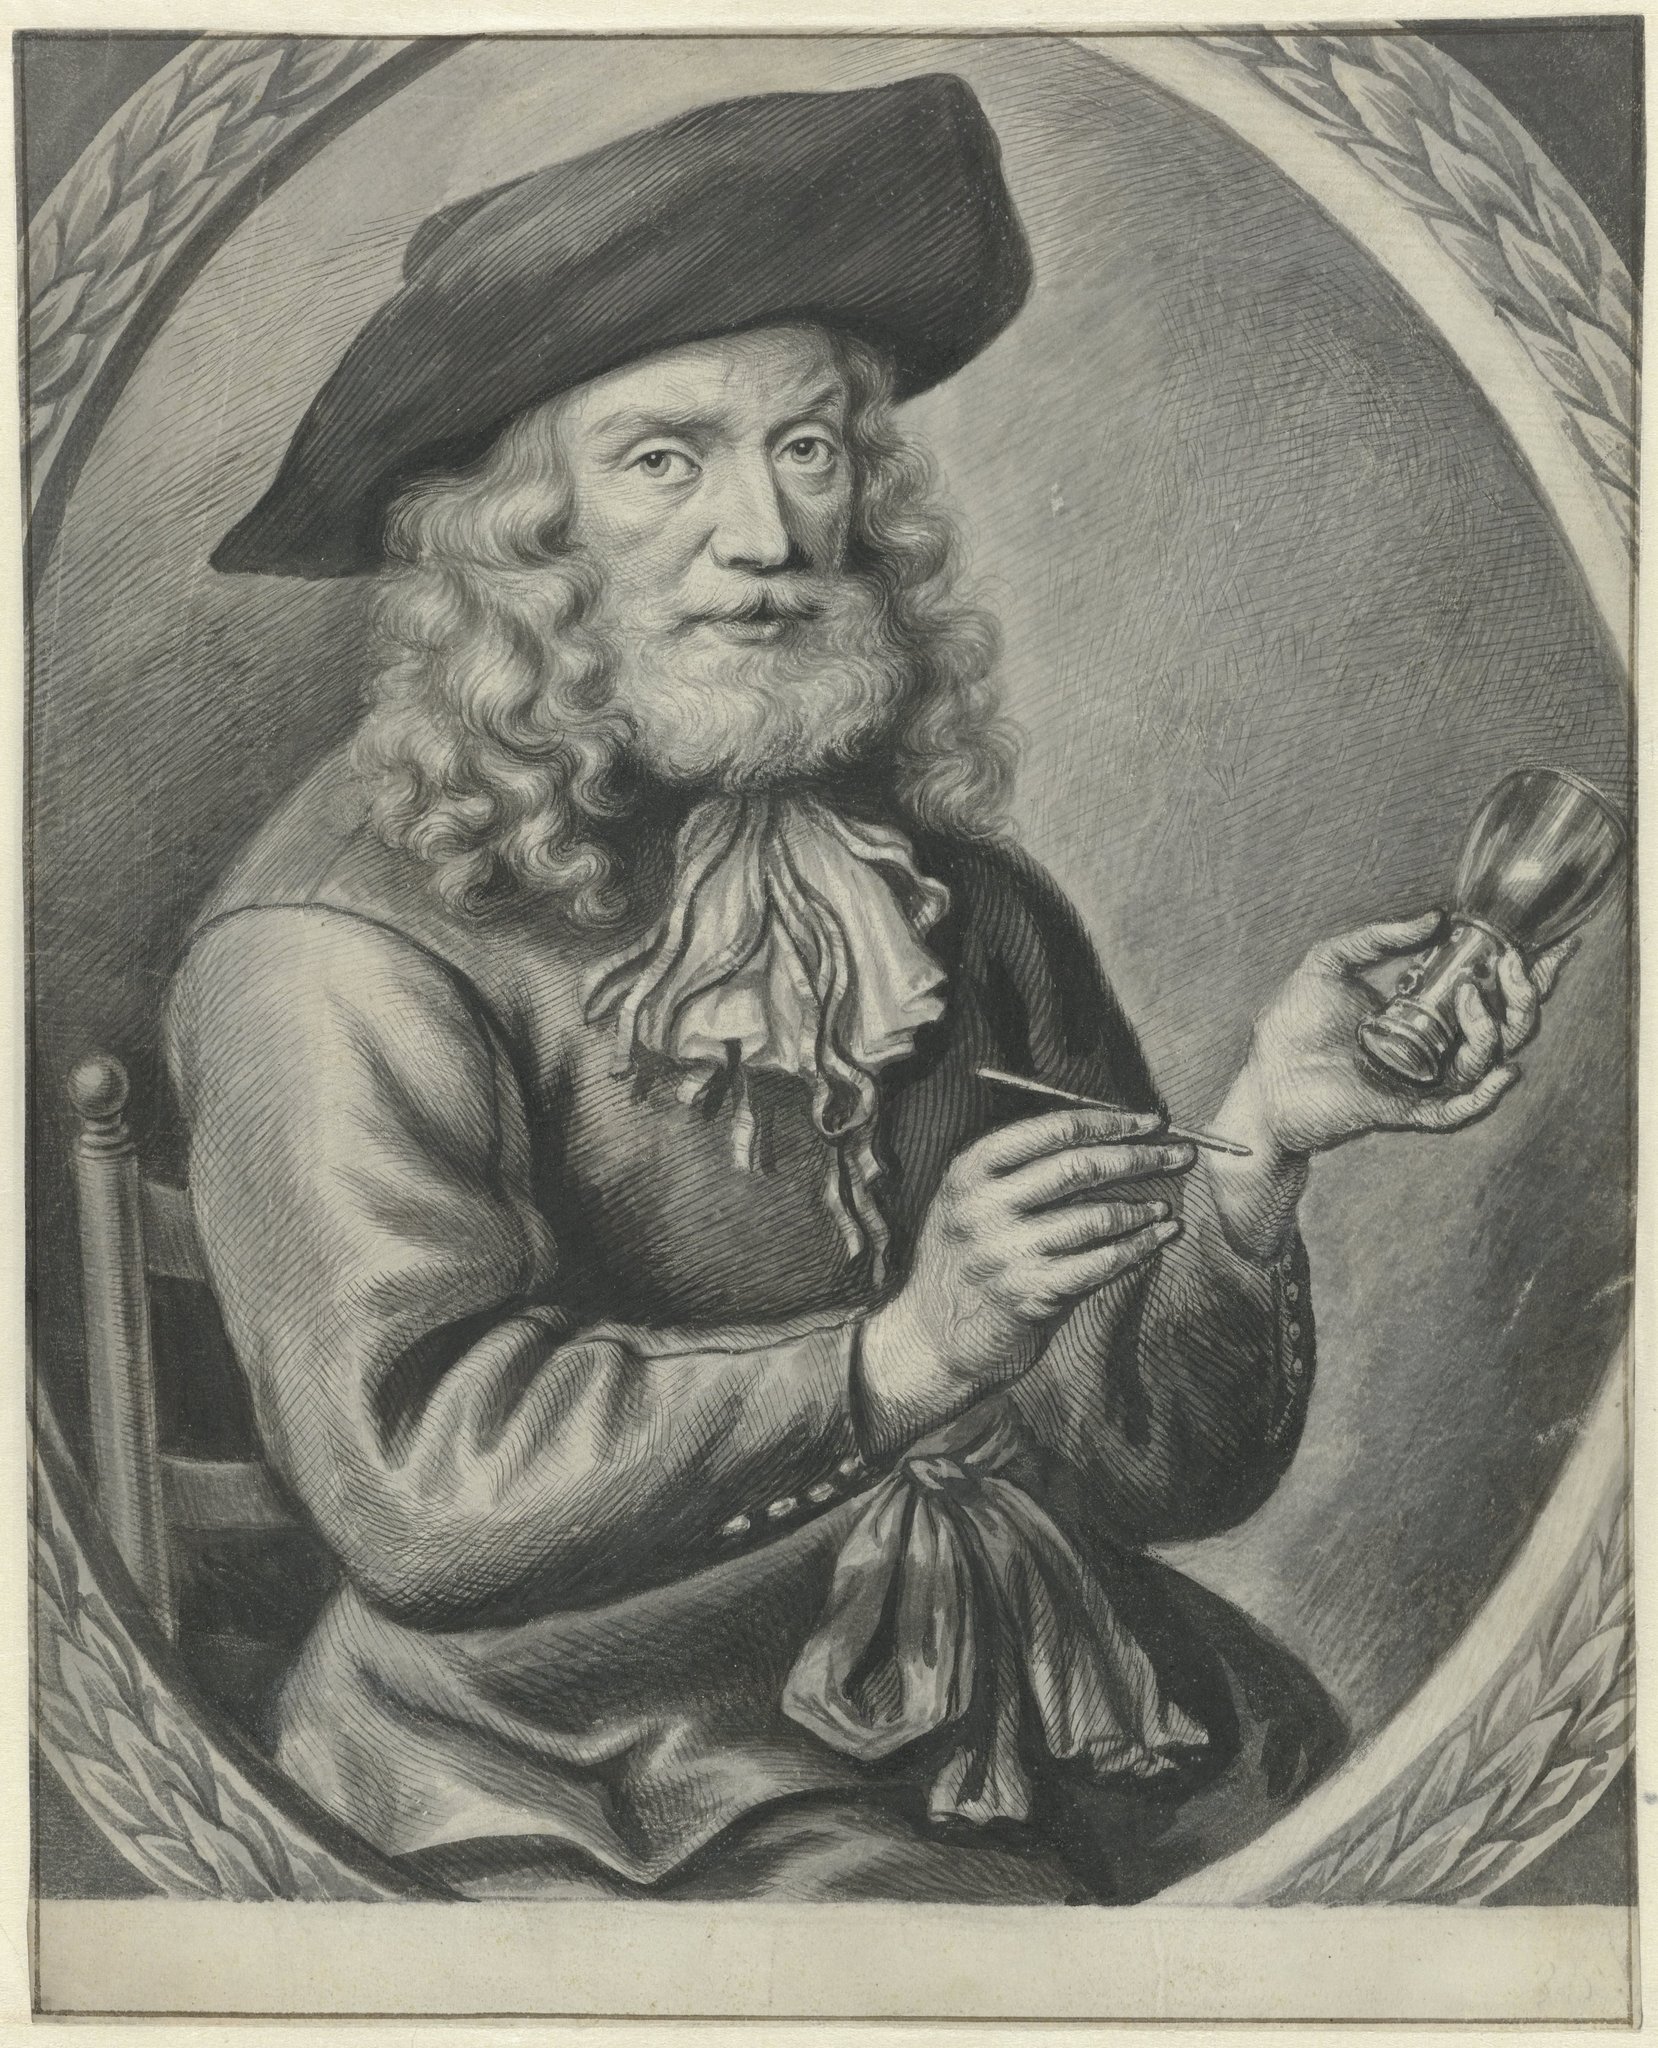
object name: drawing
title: Portret van Pieter Jansz., glasschilder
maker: Anonymous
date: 1670-1680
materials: ink, parchment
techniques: brush, pen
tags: amsterdam, draughtsman, pieter jansz, historical persons, portrait, self-portrait of painter, portrait, self-portrait of artist